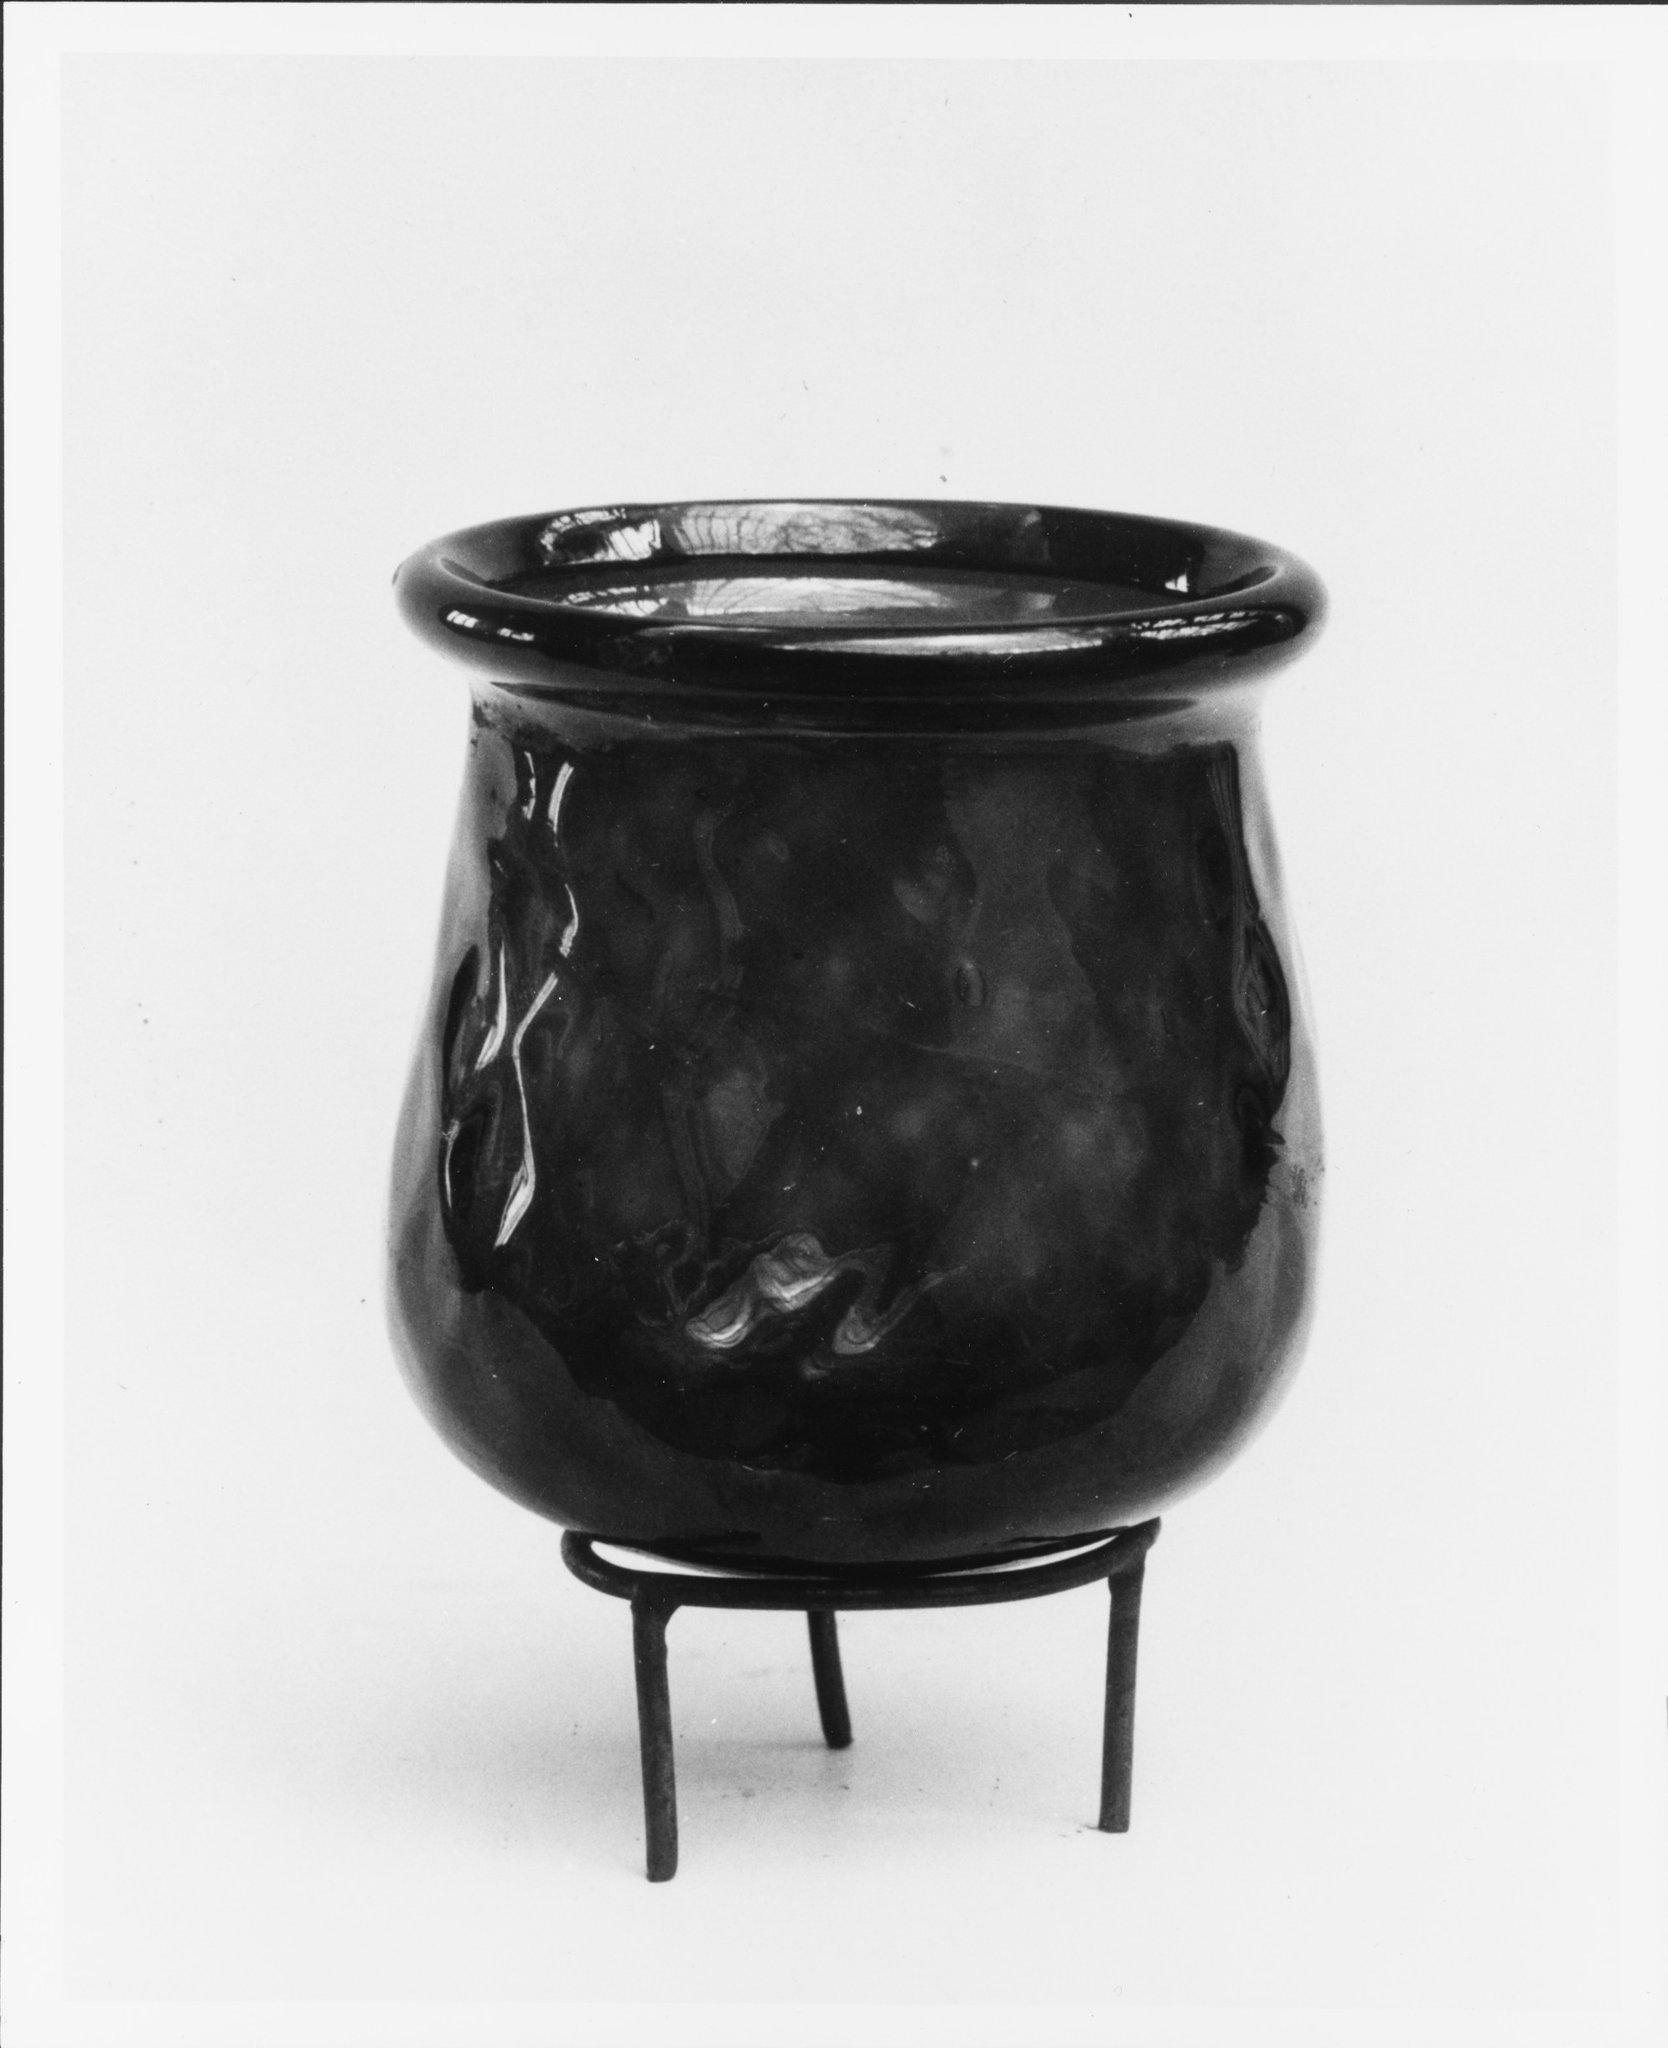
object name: hanging light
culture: american or british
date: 1780-1825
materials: glass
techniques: glassblowing, molding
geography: england